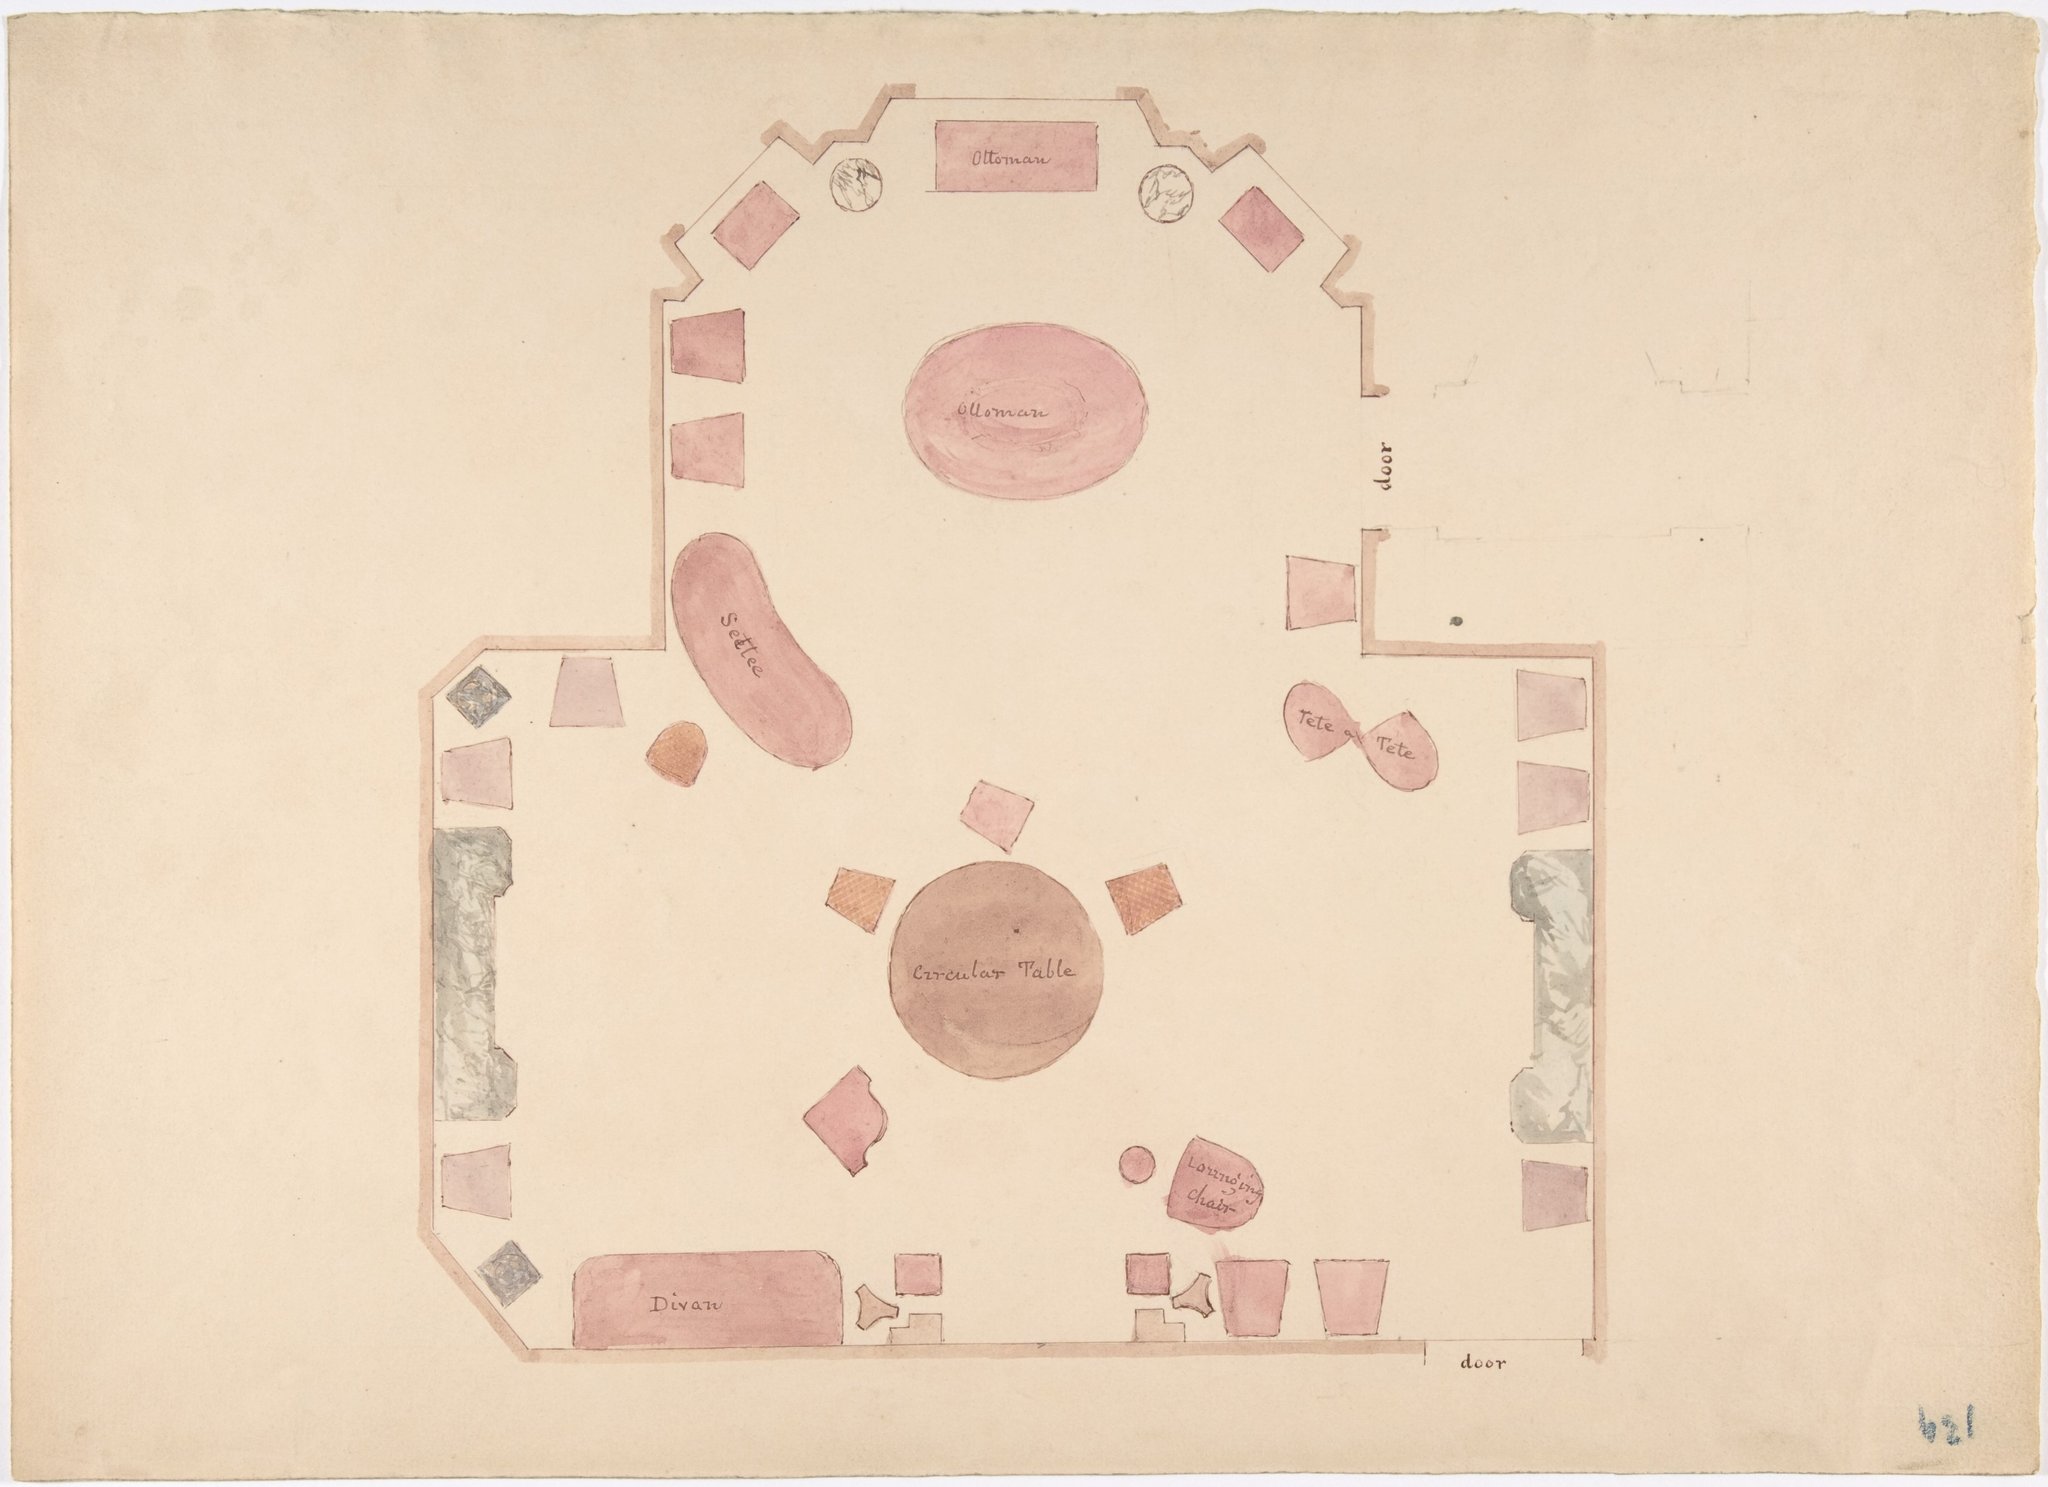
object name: drawing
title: Plan of a Room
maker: anonymous, british, 19th century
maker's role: artist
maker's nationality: british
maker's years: 1800-1900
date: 1801-1833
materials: ink, watercolor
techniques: brush, pen, wash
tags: architecture,interiors